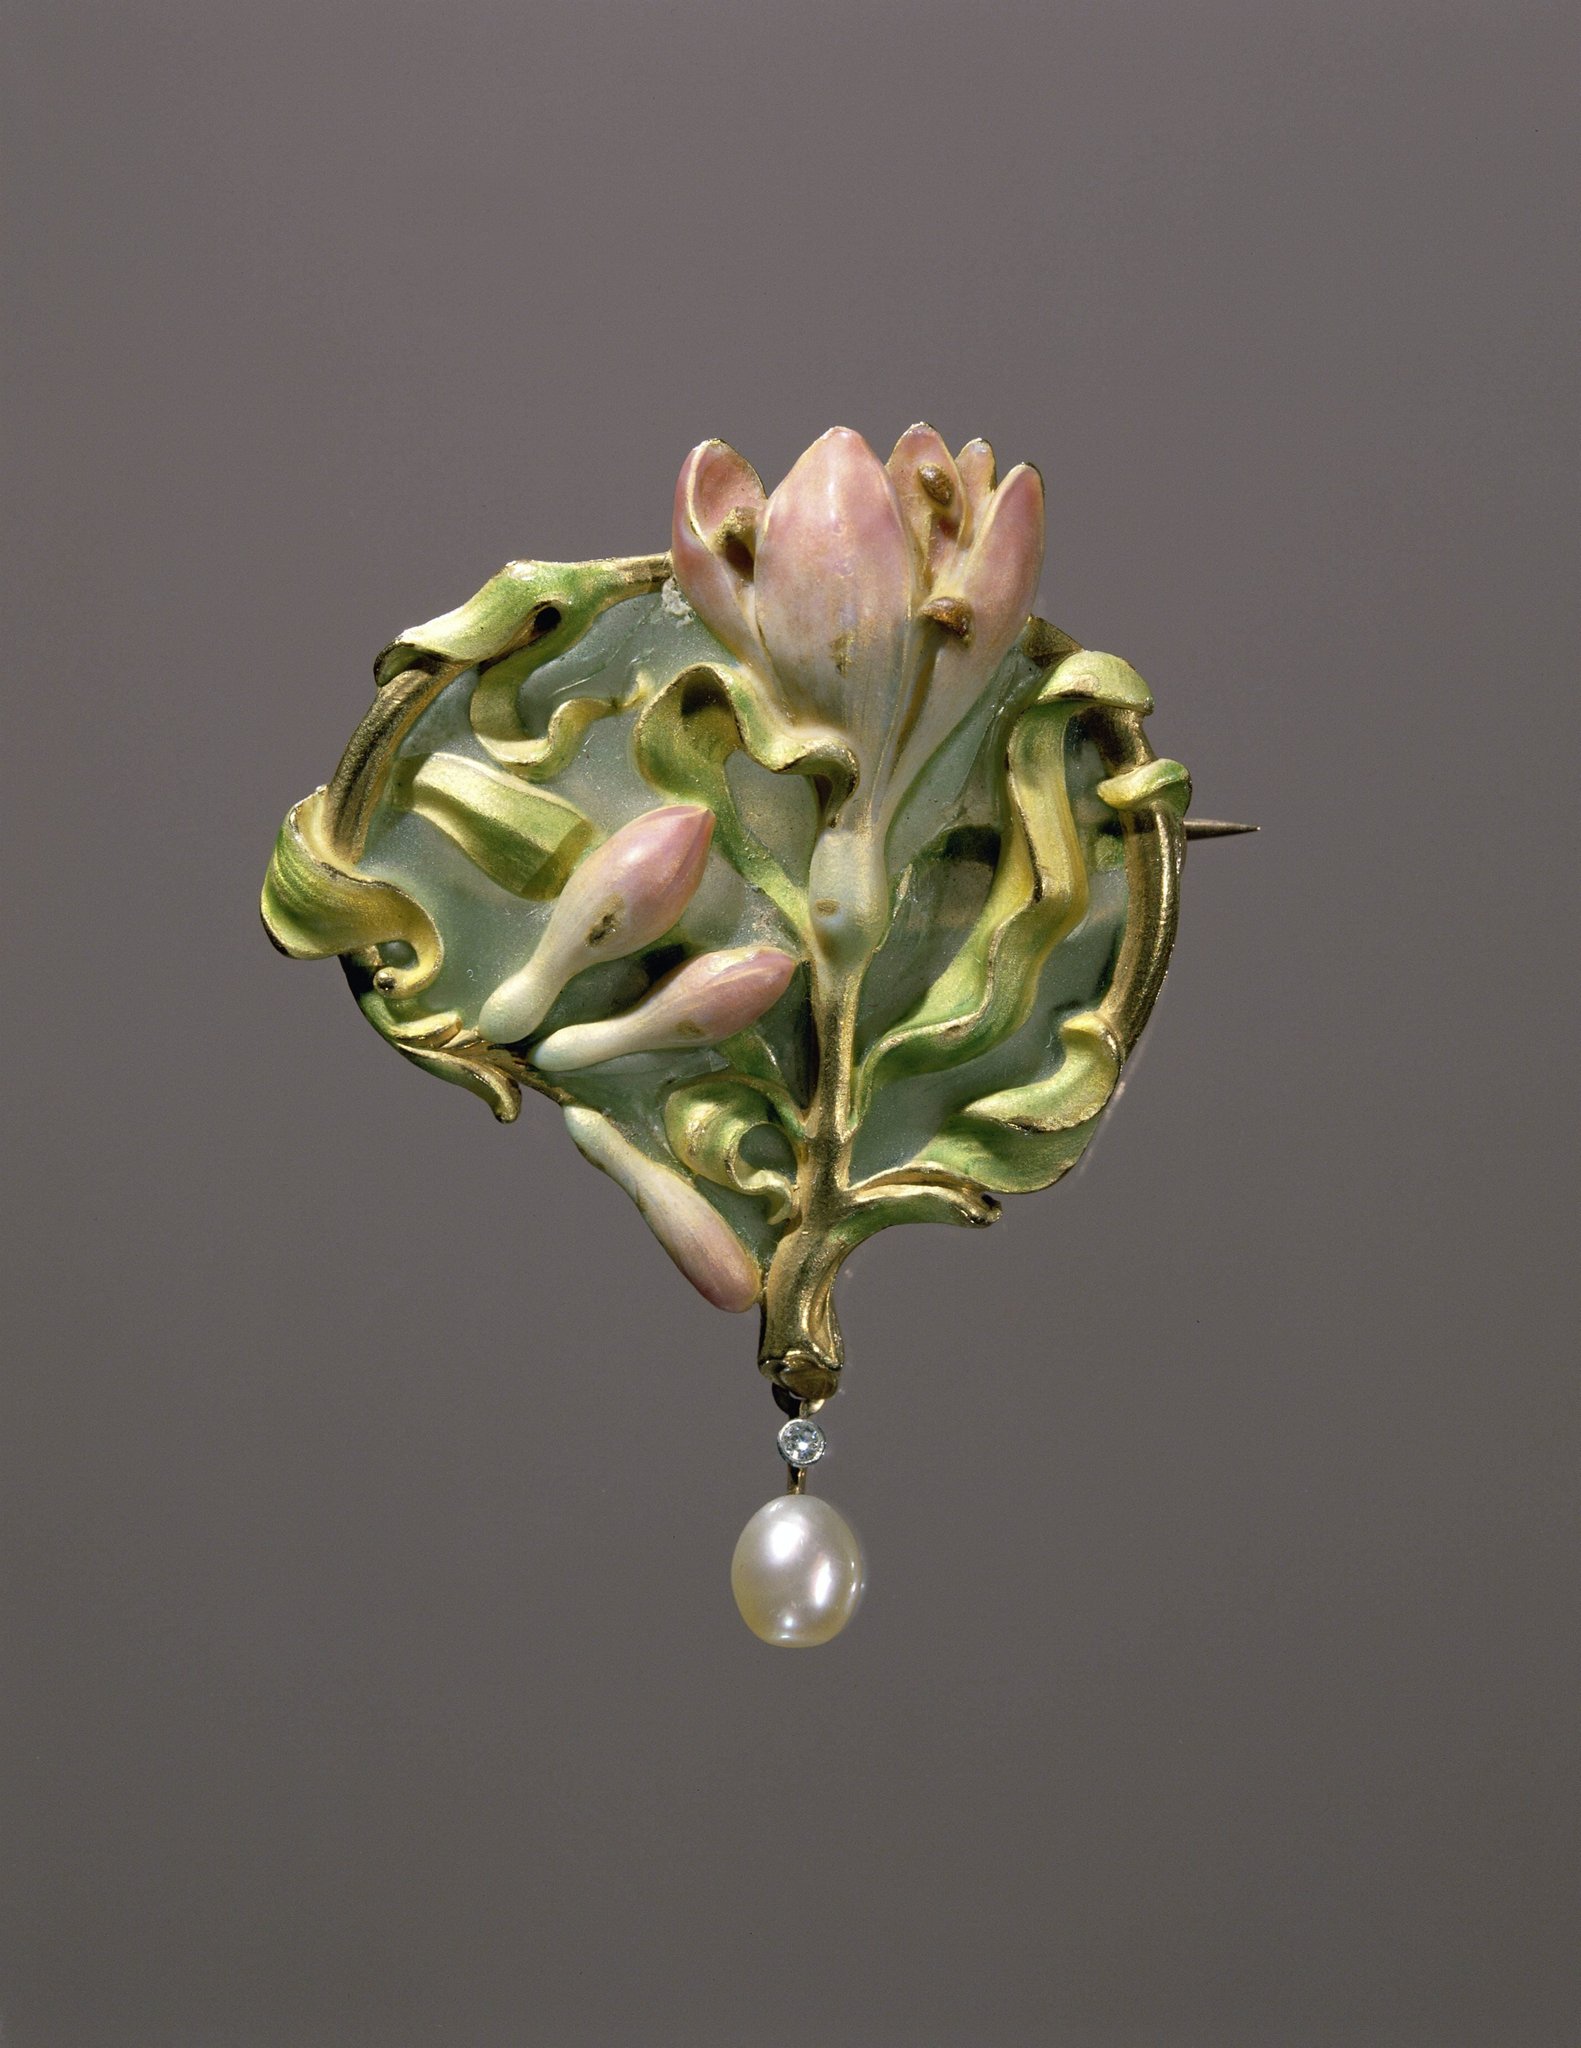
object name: brooch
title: Broche in de vorm van fresiabloemen en bladeren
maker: albert chambin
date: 1900-1910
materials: diamond, gold, pearl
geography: paris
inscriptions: alloy mark: ‘adelaarskop naar rechts’, maker's mark: ‘AC waartussen een klaverblad in ruit’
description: Broche van goud, diamant, parel en email. In de vorm van enkele fresiabloemen en -bladeren, in art nouveau-stijl